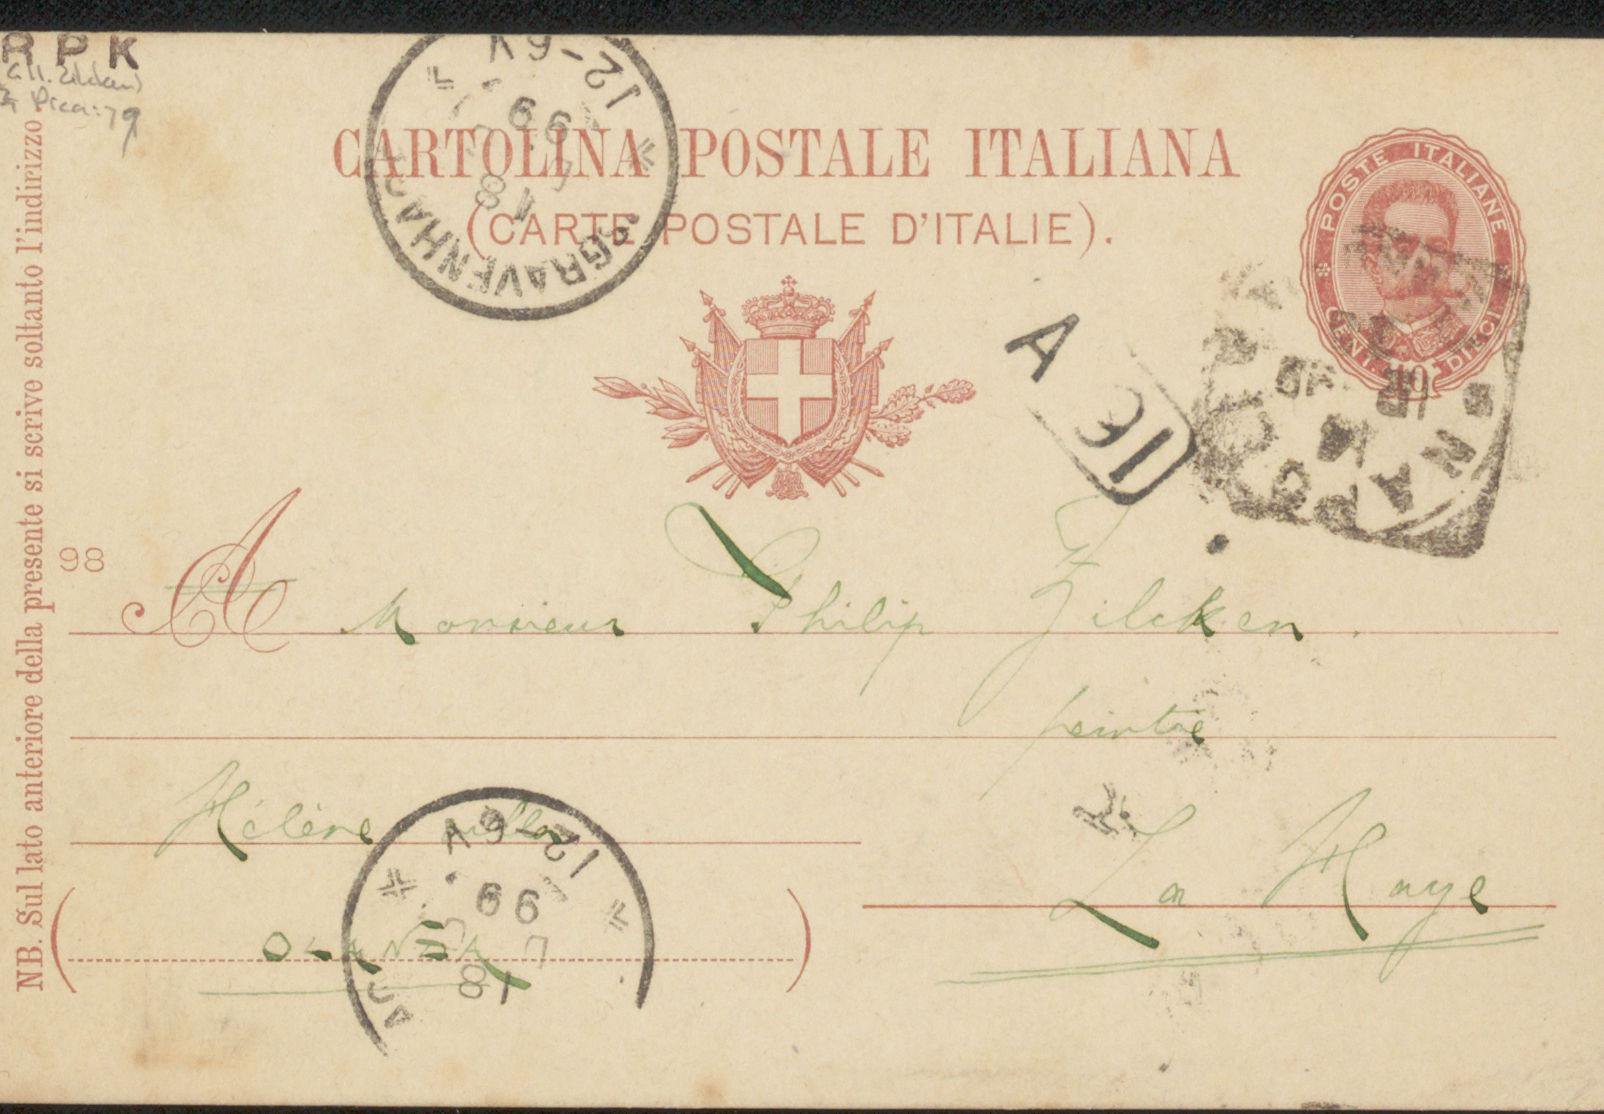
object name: postcard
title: Briefkaart aan Philip Zilcken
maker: vittorio pica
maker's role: criticus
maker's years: 1864-1930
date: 1899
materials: cardboard, ink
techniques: pen, writing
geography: naples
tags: painter, draughtsman, philip zilcken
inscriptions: collector's mark: ‘RPK’